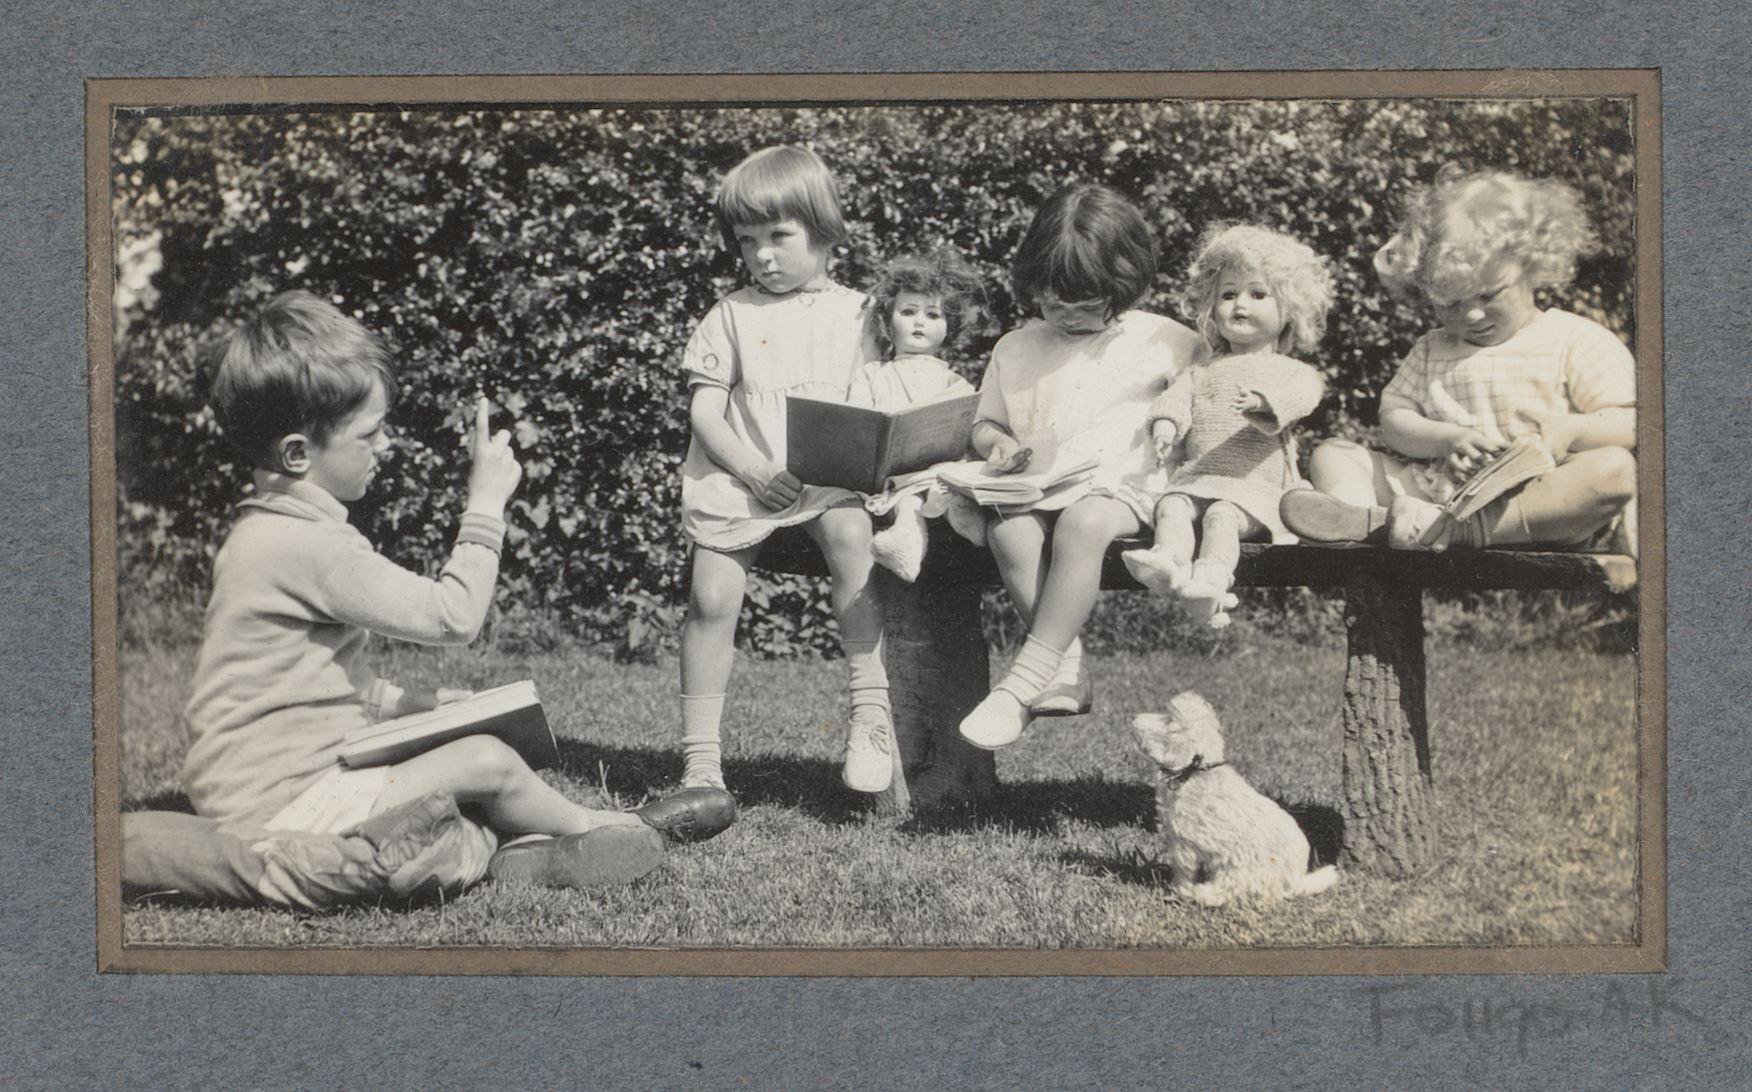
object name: album leaf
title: Kinderen spelen buiten met poppen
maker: Anonymous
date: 1916-1927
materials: photographic support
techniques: gelatin silver print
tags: child, (playing with) dolls, anonymous historical persons portrayed in a group, in a group-portrait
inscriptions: inscription: ‘Opnamen gemaakt met de Zak-"Kodak" No. 2c./ Afdrukken gemaakt op "Velox" papier’